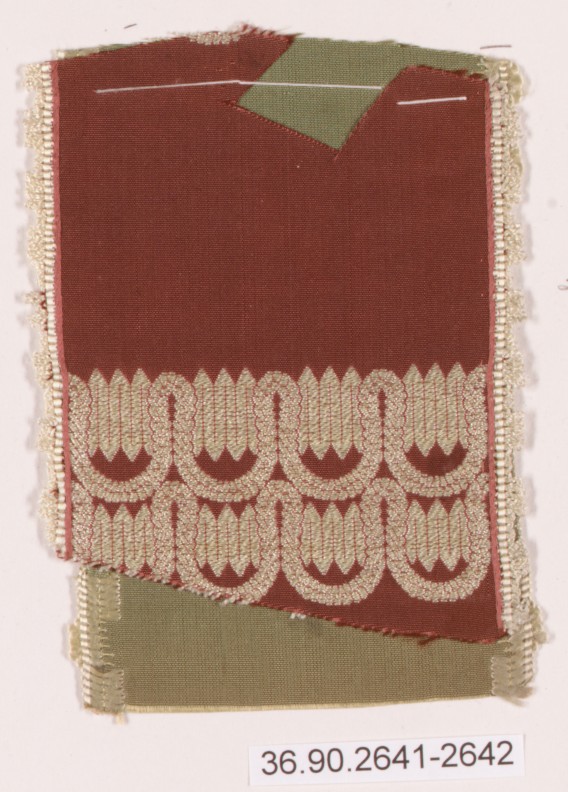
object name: ribbon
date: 1801-1900